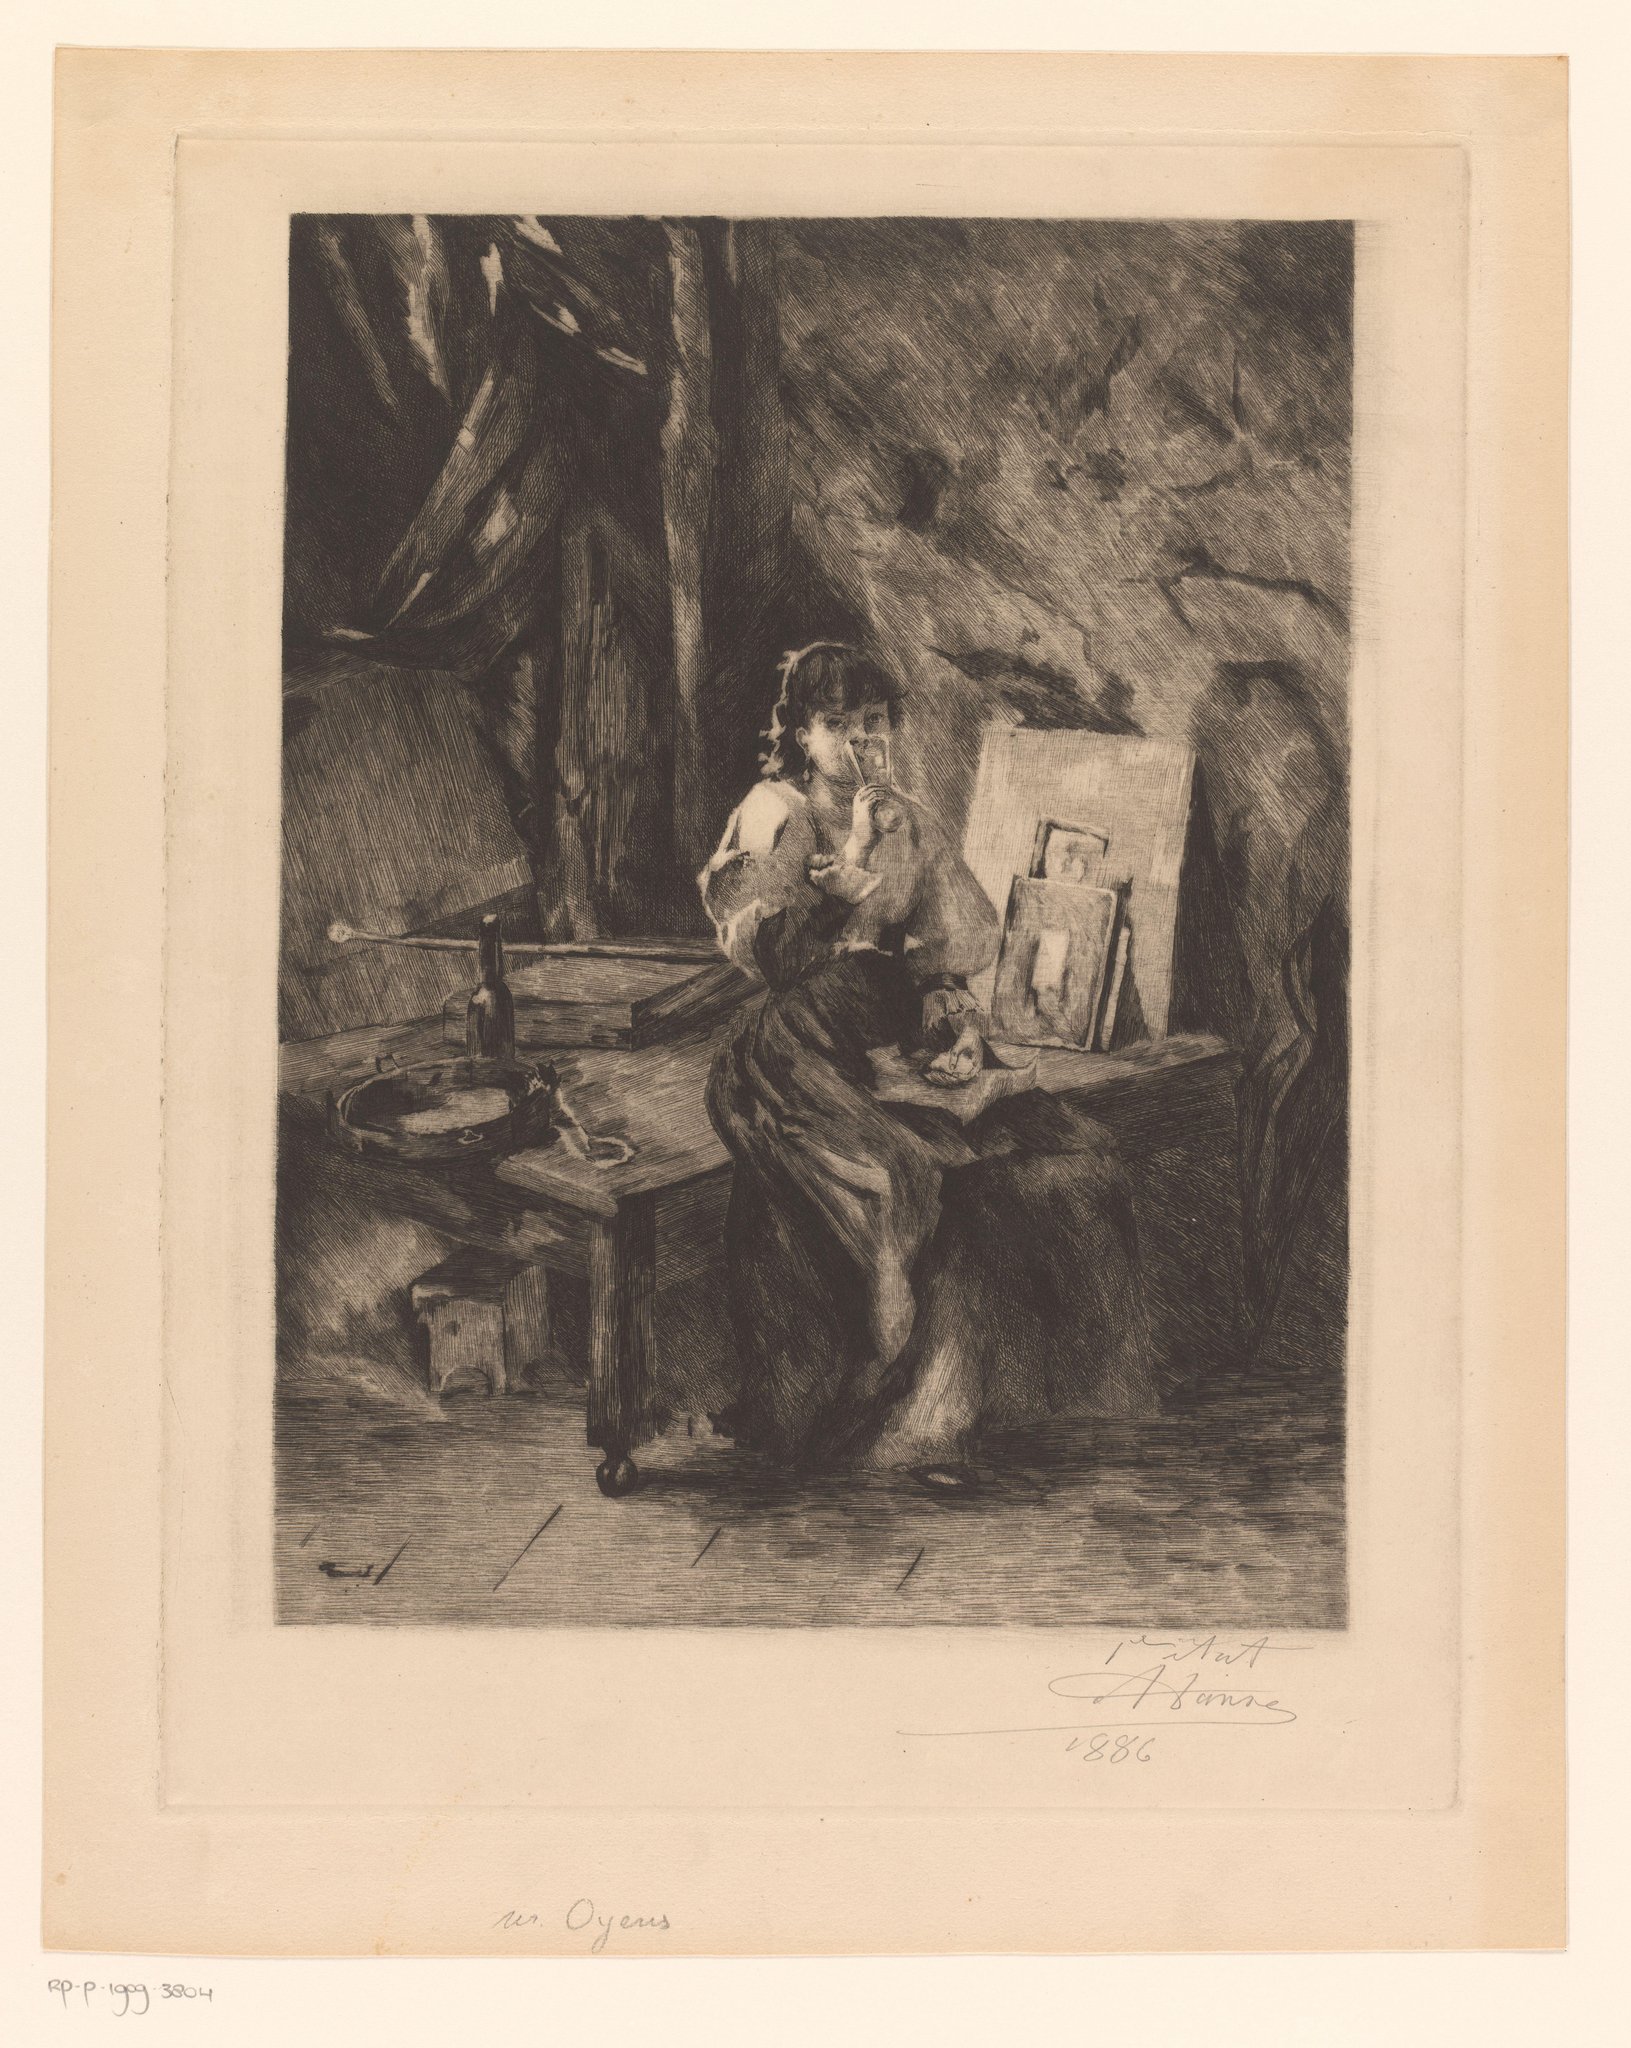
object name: print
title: Rustend model in het atelier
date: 1886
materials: paper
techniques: etching, intaglio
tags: artist's model, sitter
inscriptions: annotation: ‘1er etat’, collector's mark: Lugt 2228